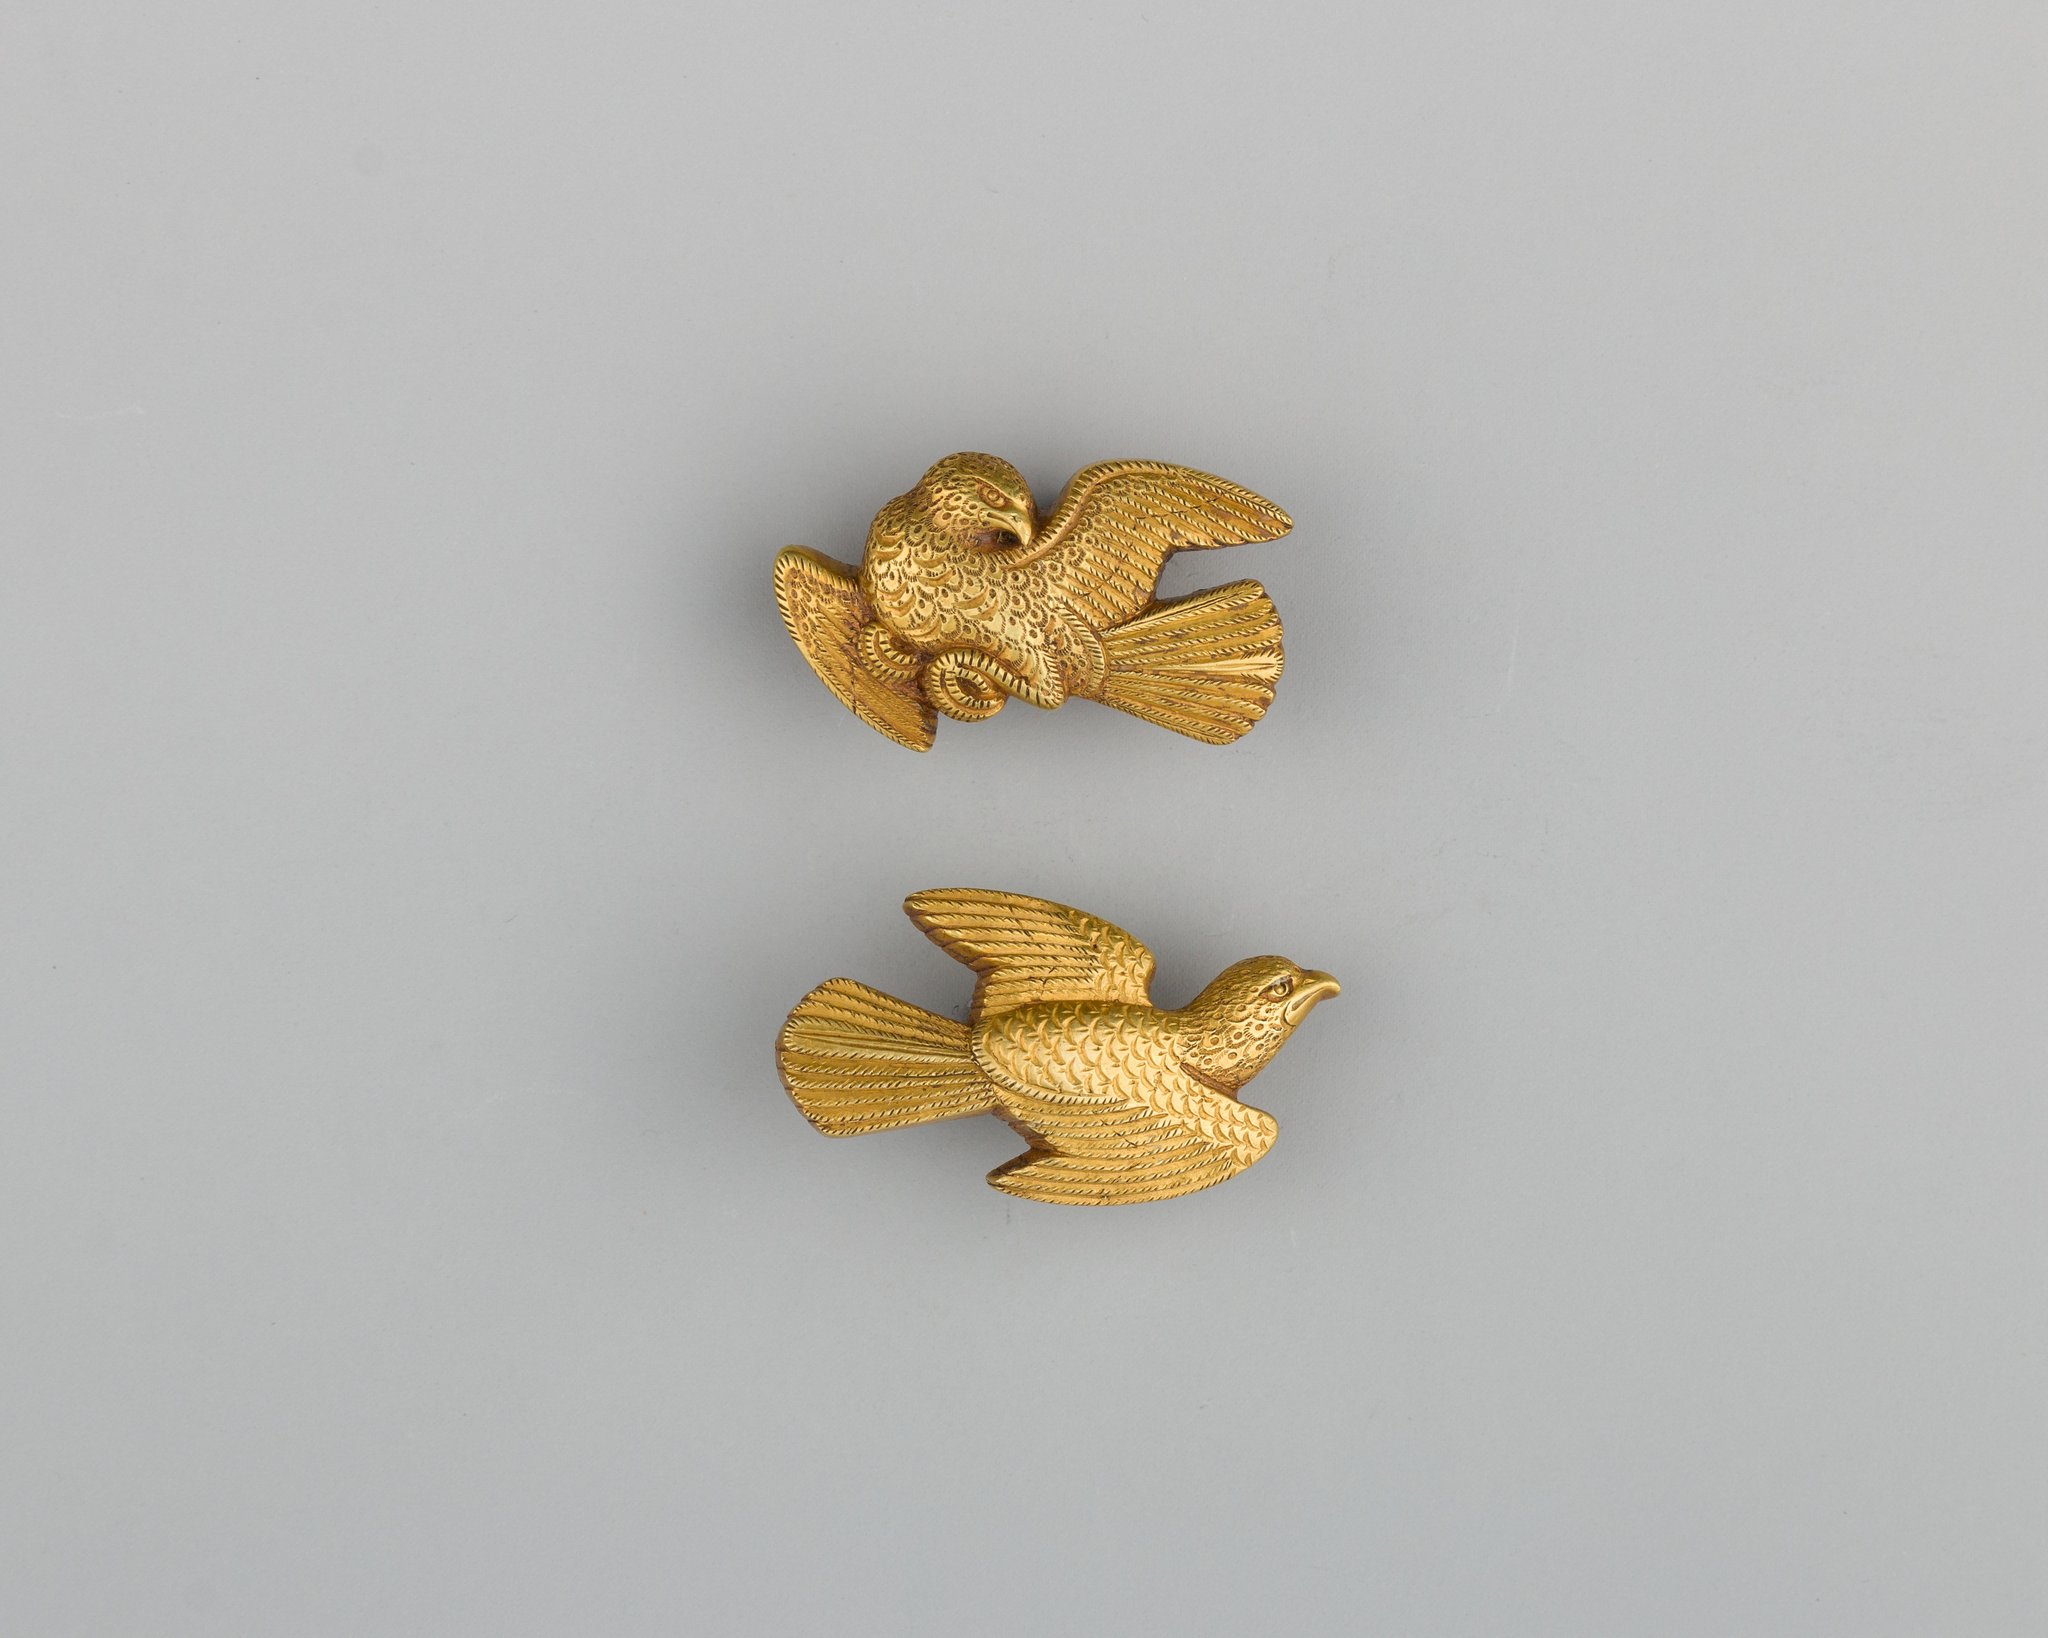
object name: pair of sword grip ornament menuki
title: Pair of Sword-Grip Ornaments (Menuki)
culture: japanese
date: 1701-1800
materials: gold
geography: japan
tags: birds